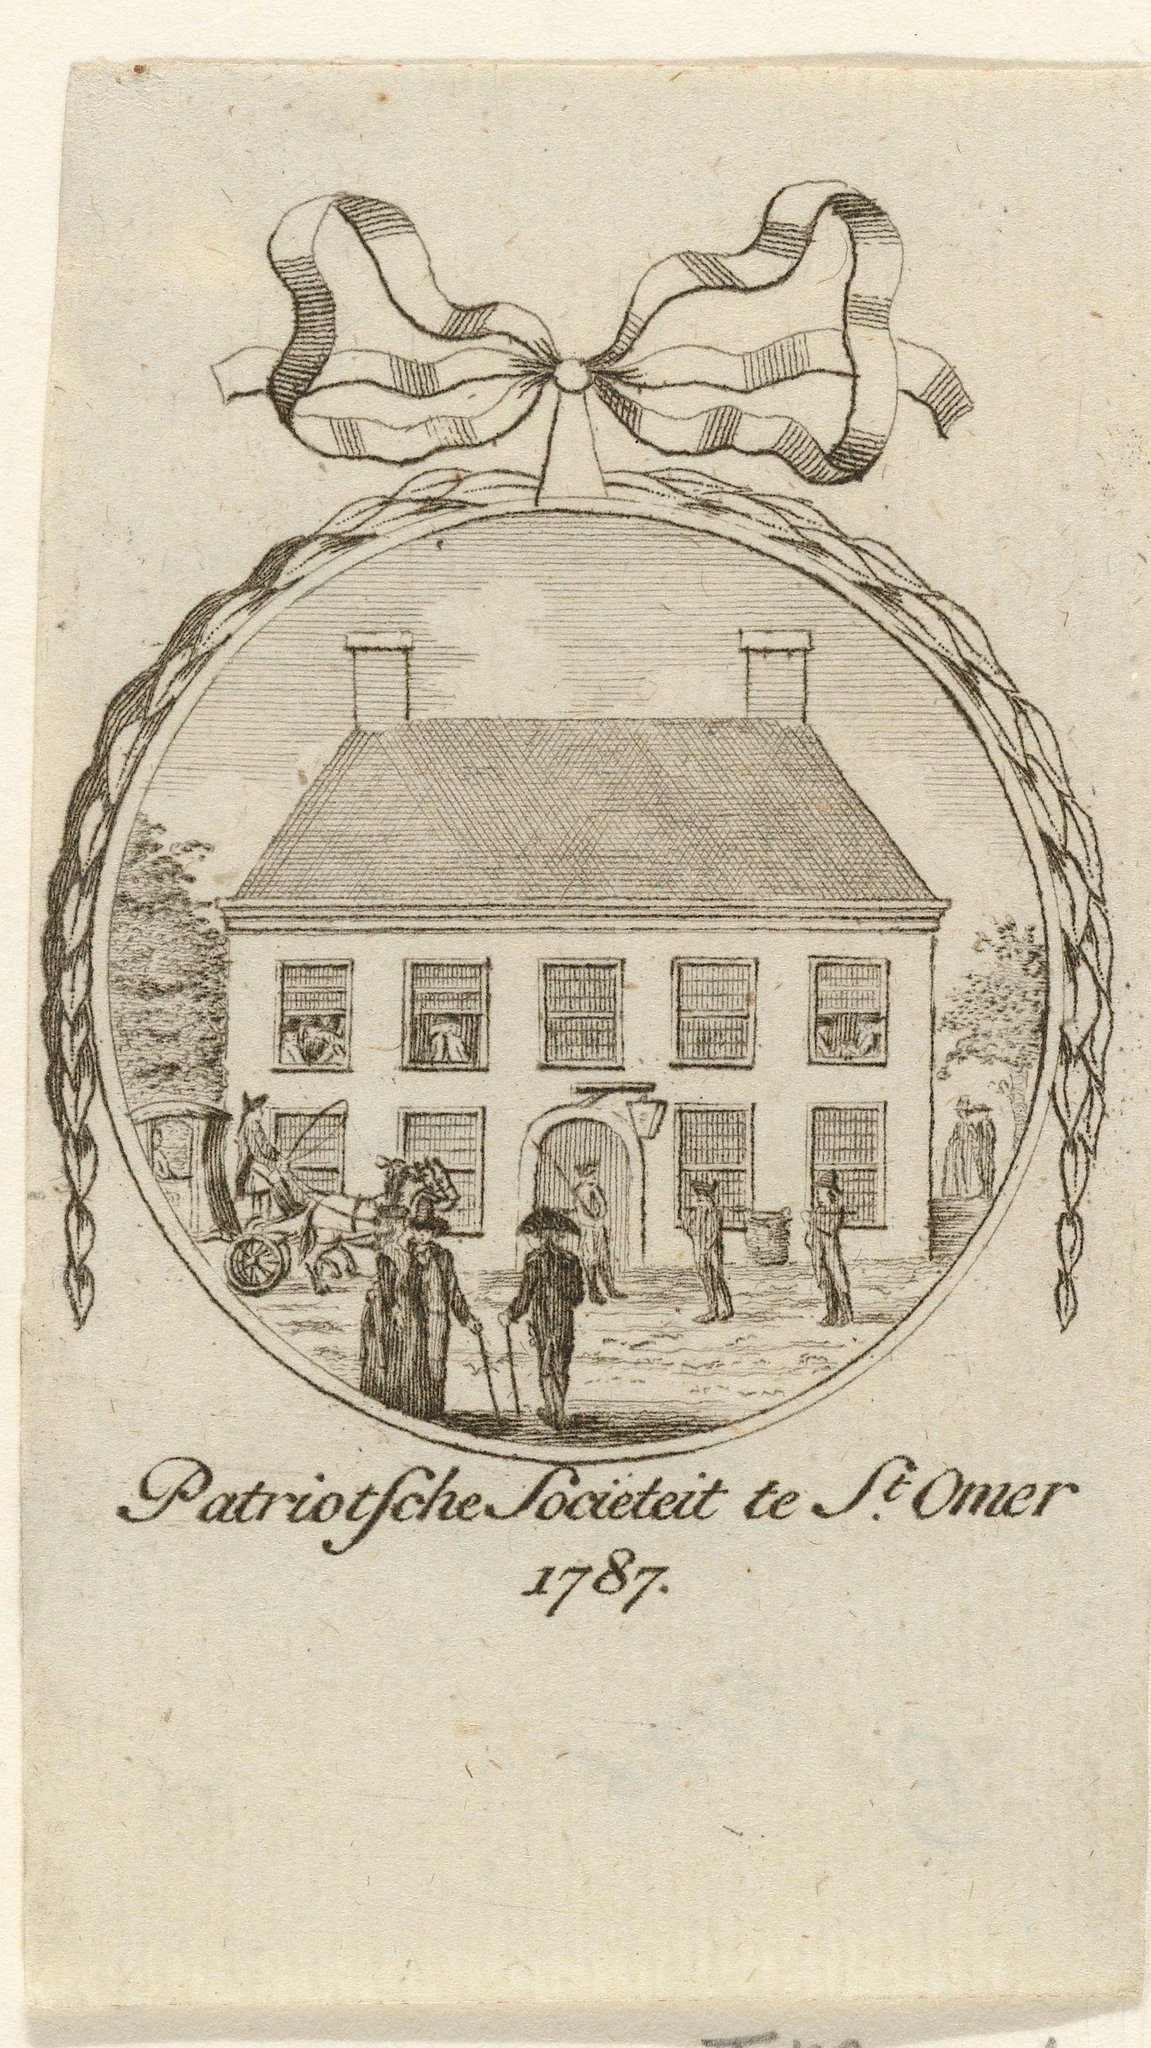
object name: print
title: Patriotsche Societeit te St. Omer 1787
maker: Anonymous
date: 1790-1792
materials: paper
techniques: engraving, etching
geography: northern netherlands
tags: club, meeting place, patriots (1780-1795)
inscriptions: collector's mark: Lugt 2228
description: Gebruikt als illustratie in twee almanakken uitgegeven door Hendrik Arend Banse in Amsterdam 1792-1793: Nieuwe nuttige en vermaaklyke almanach en De muzykaale vaderlandsche historische almanach.